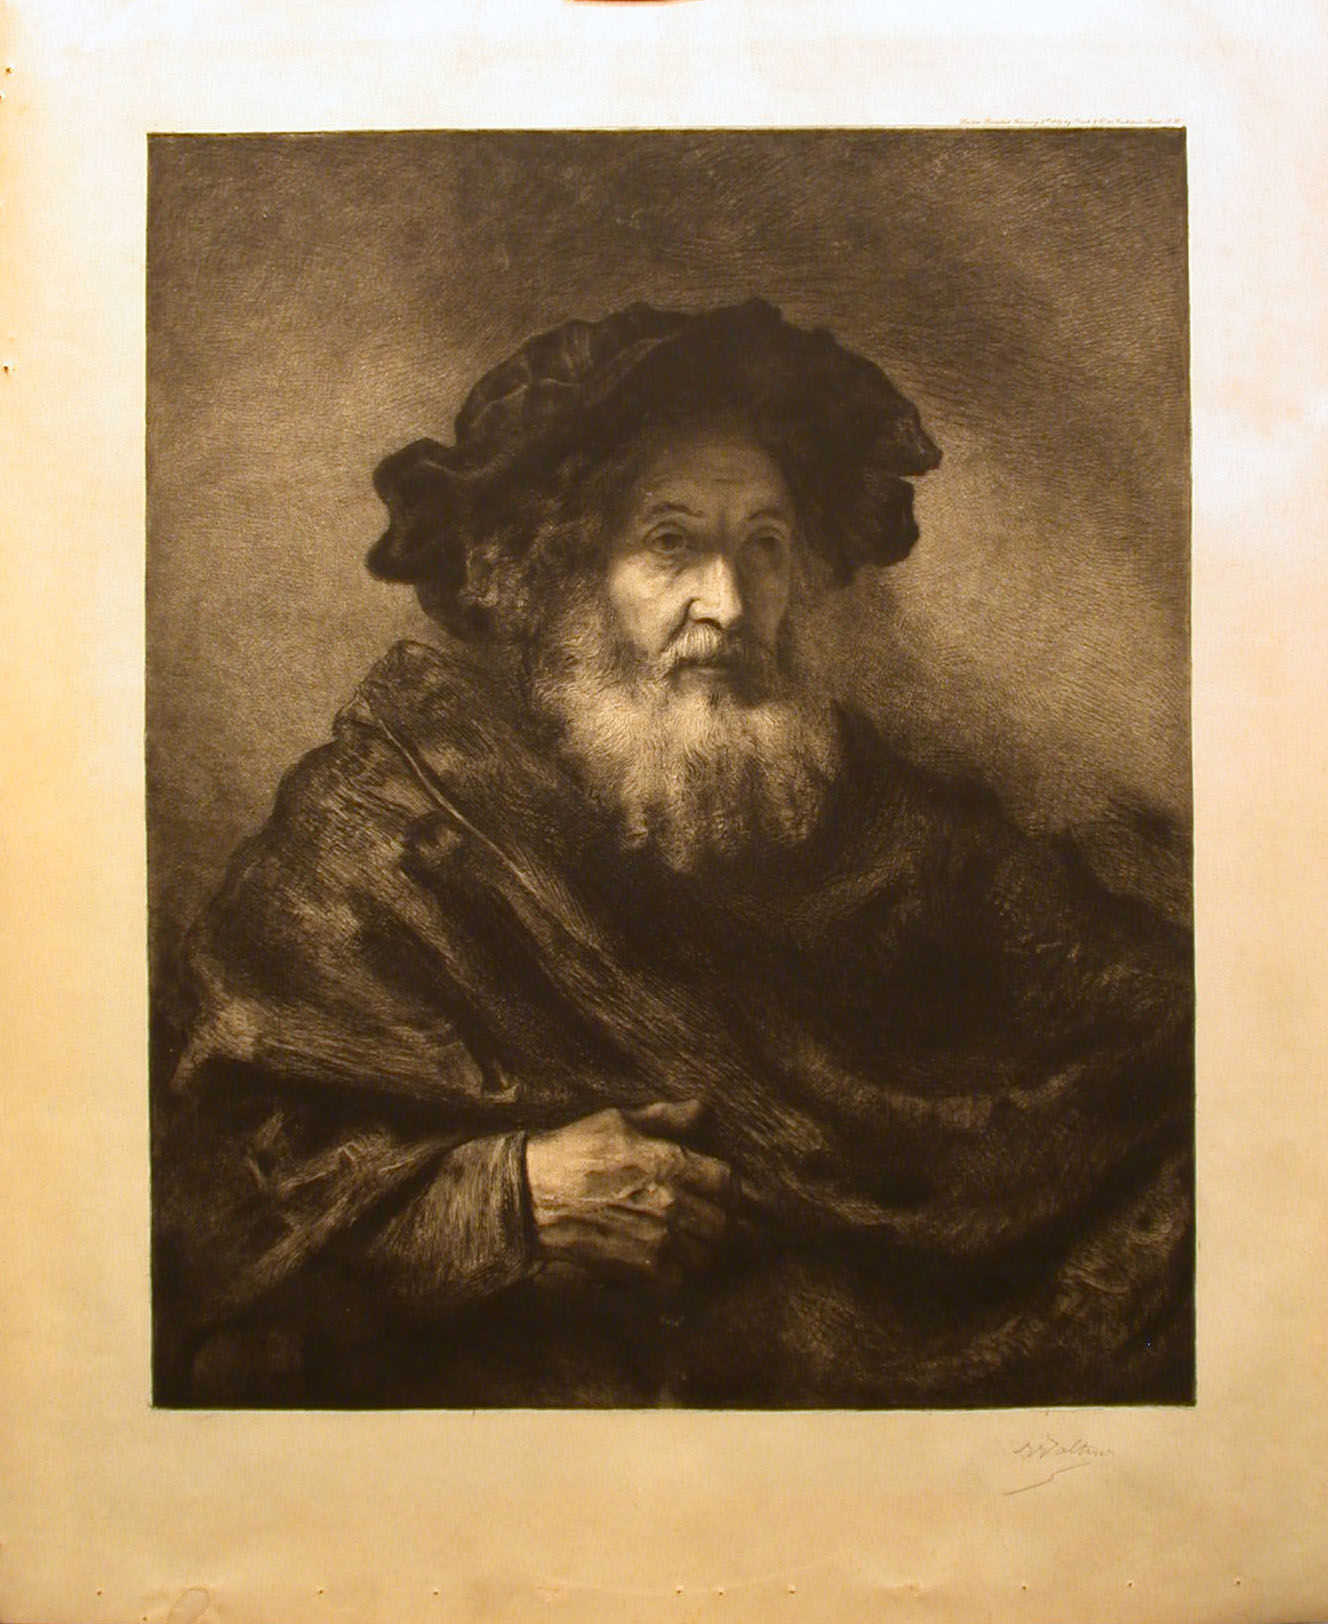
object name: print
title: Untitled: Rembrandtesque Old Man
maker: waltner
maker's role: artist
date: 1901-2000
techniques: etching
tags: men,portraits